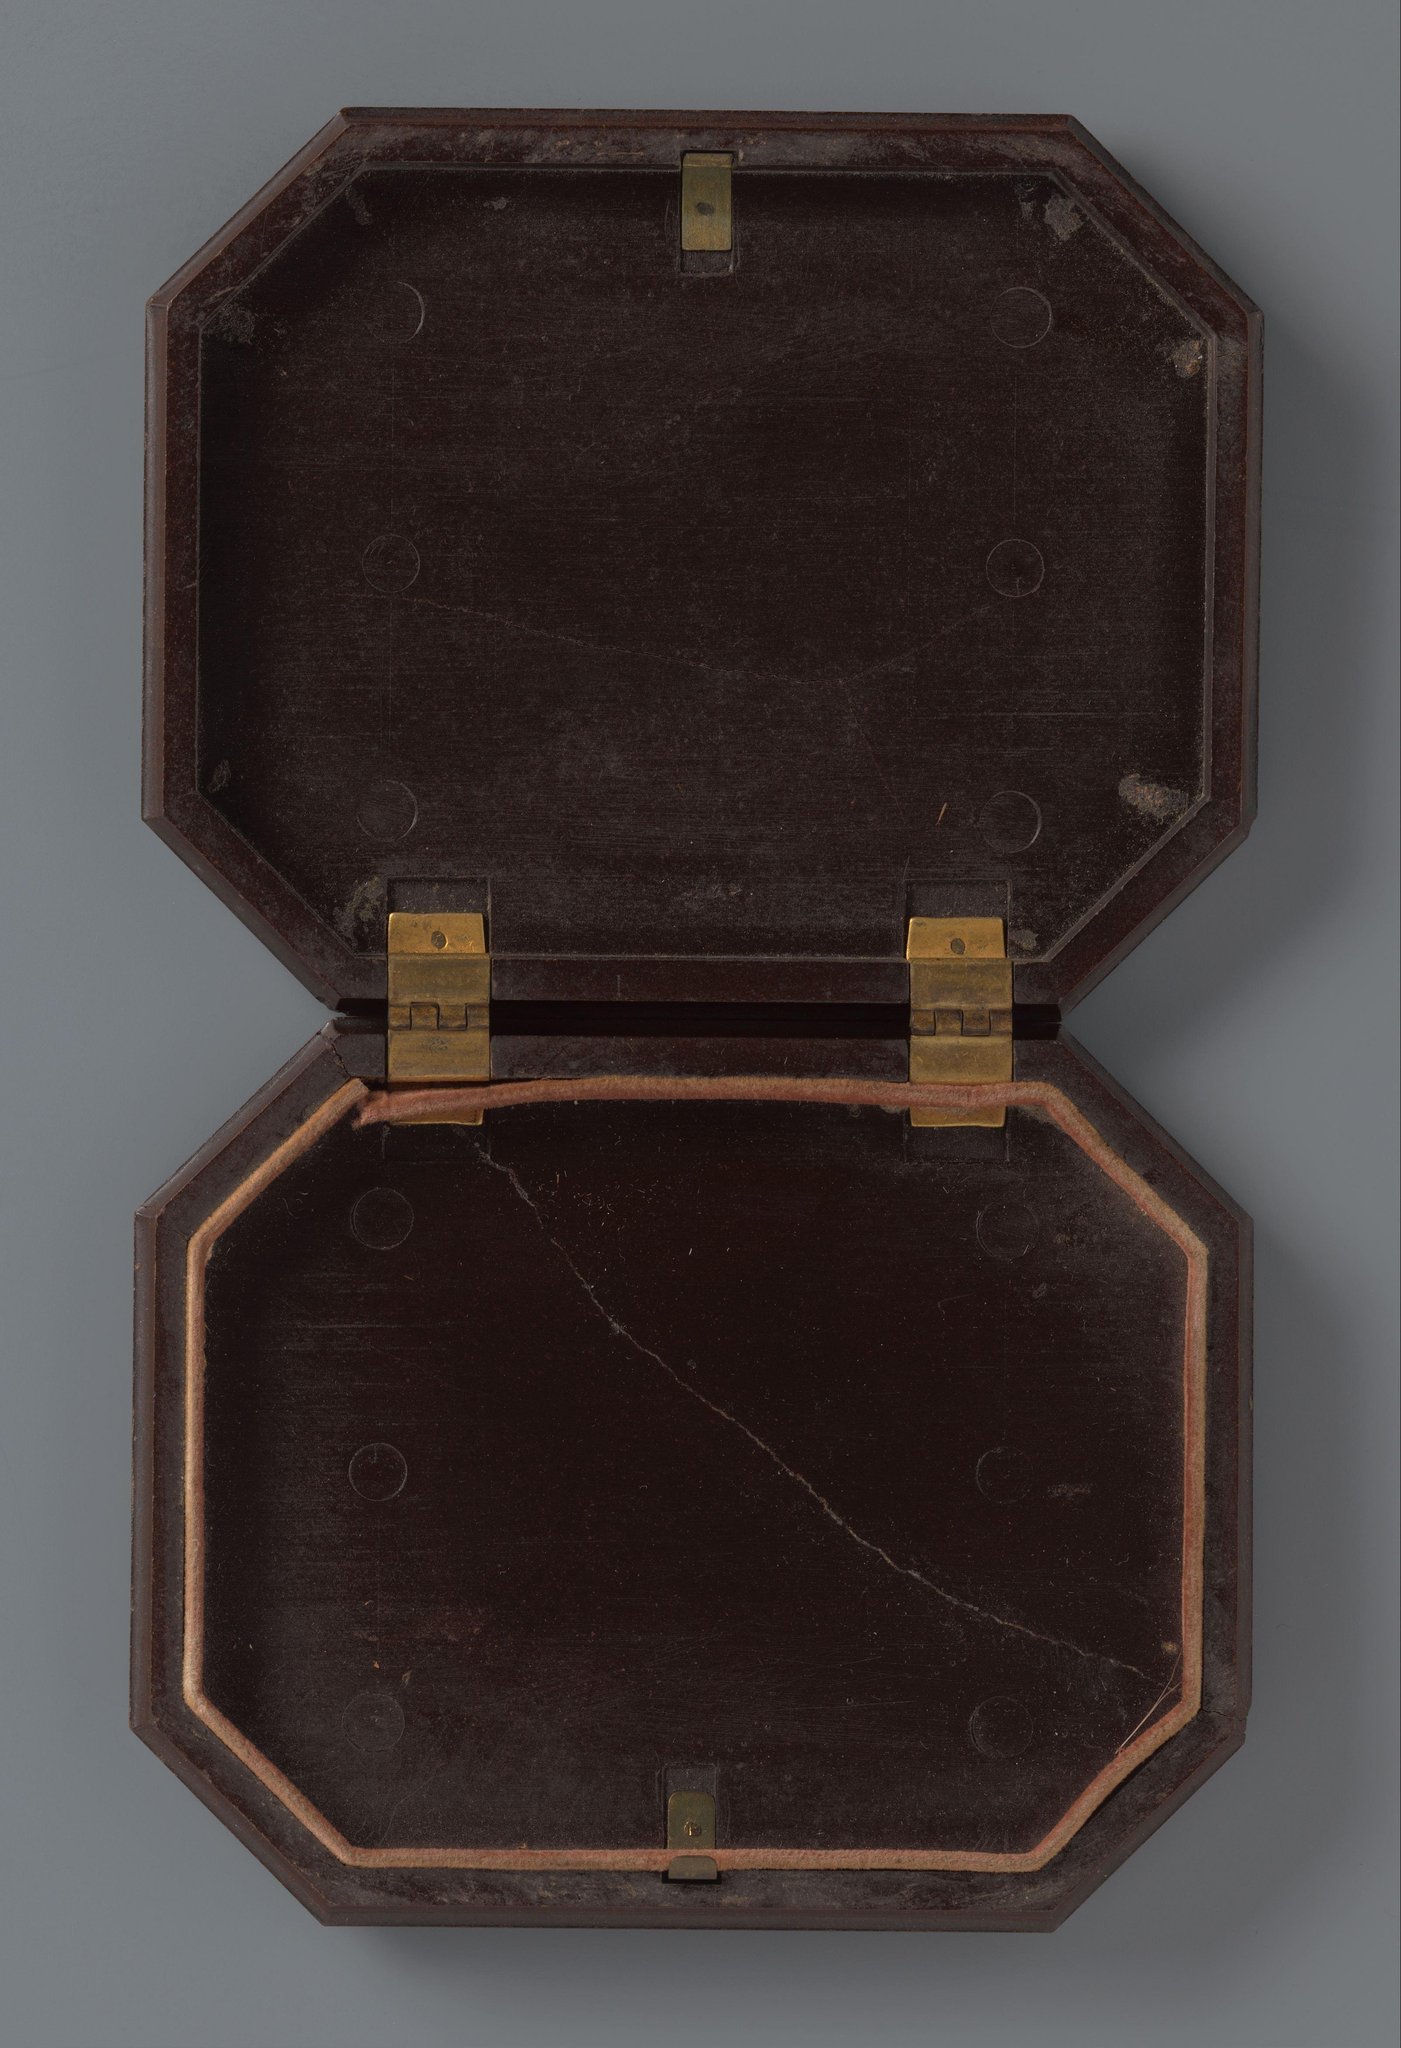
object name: union case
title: Union case (leeg)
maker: samuel peck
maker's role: manufacturer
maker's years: 1813-1879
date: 1856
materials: metal, plastic, velvet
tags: riding a horse, ass, or mule; rider, horseman, adult man (+ two persons)